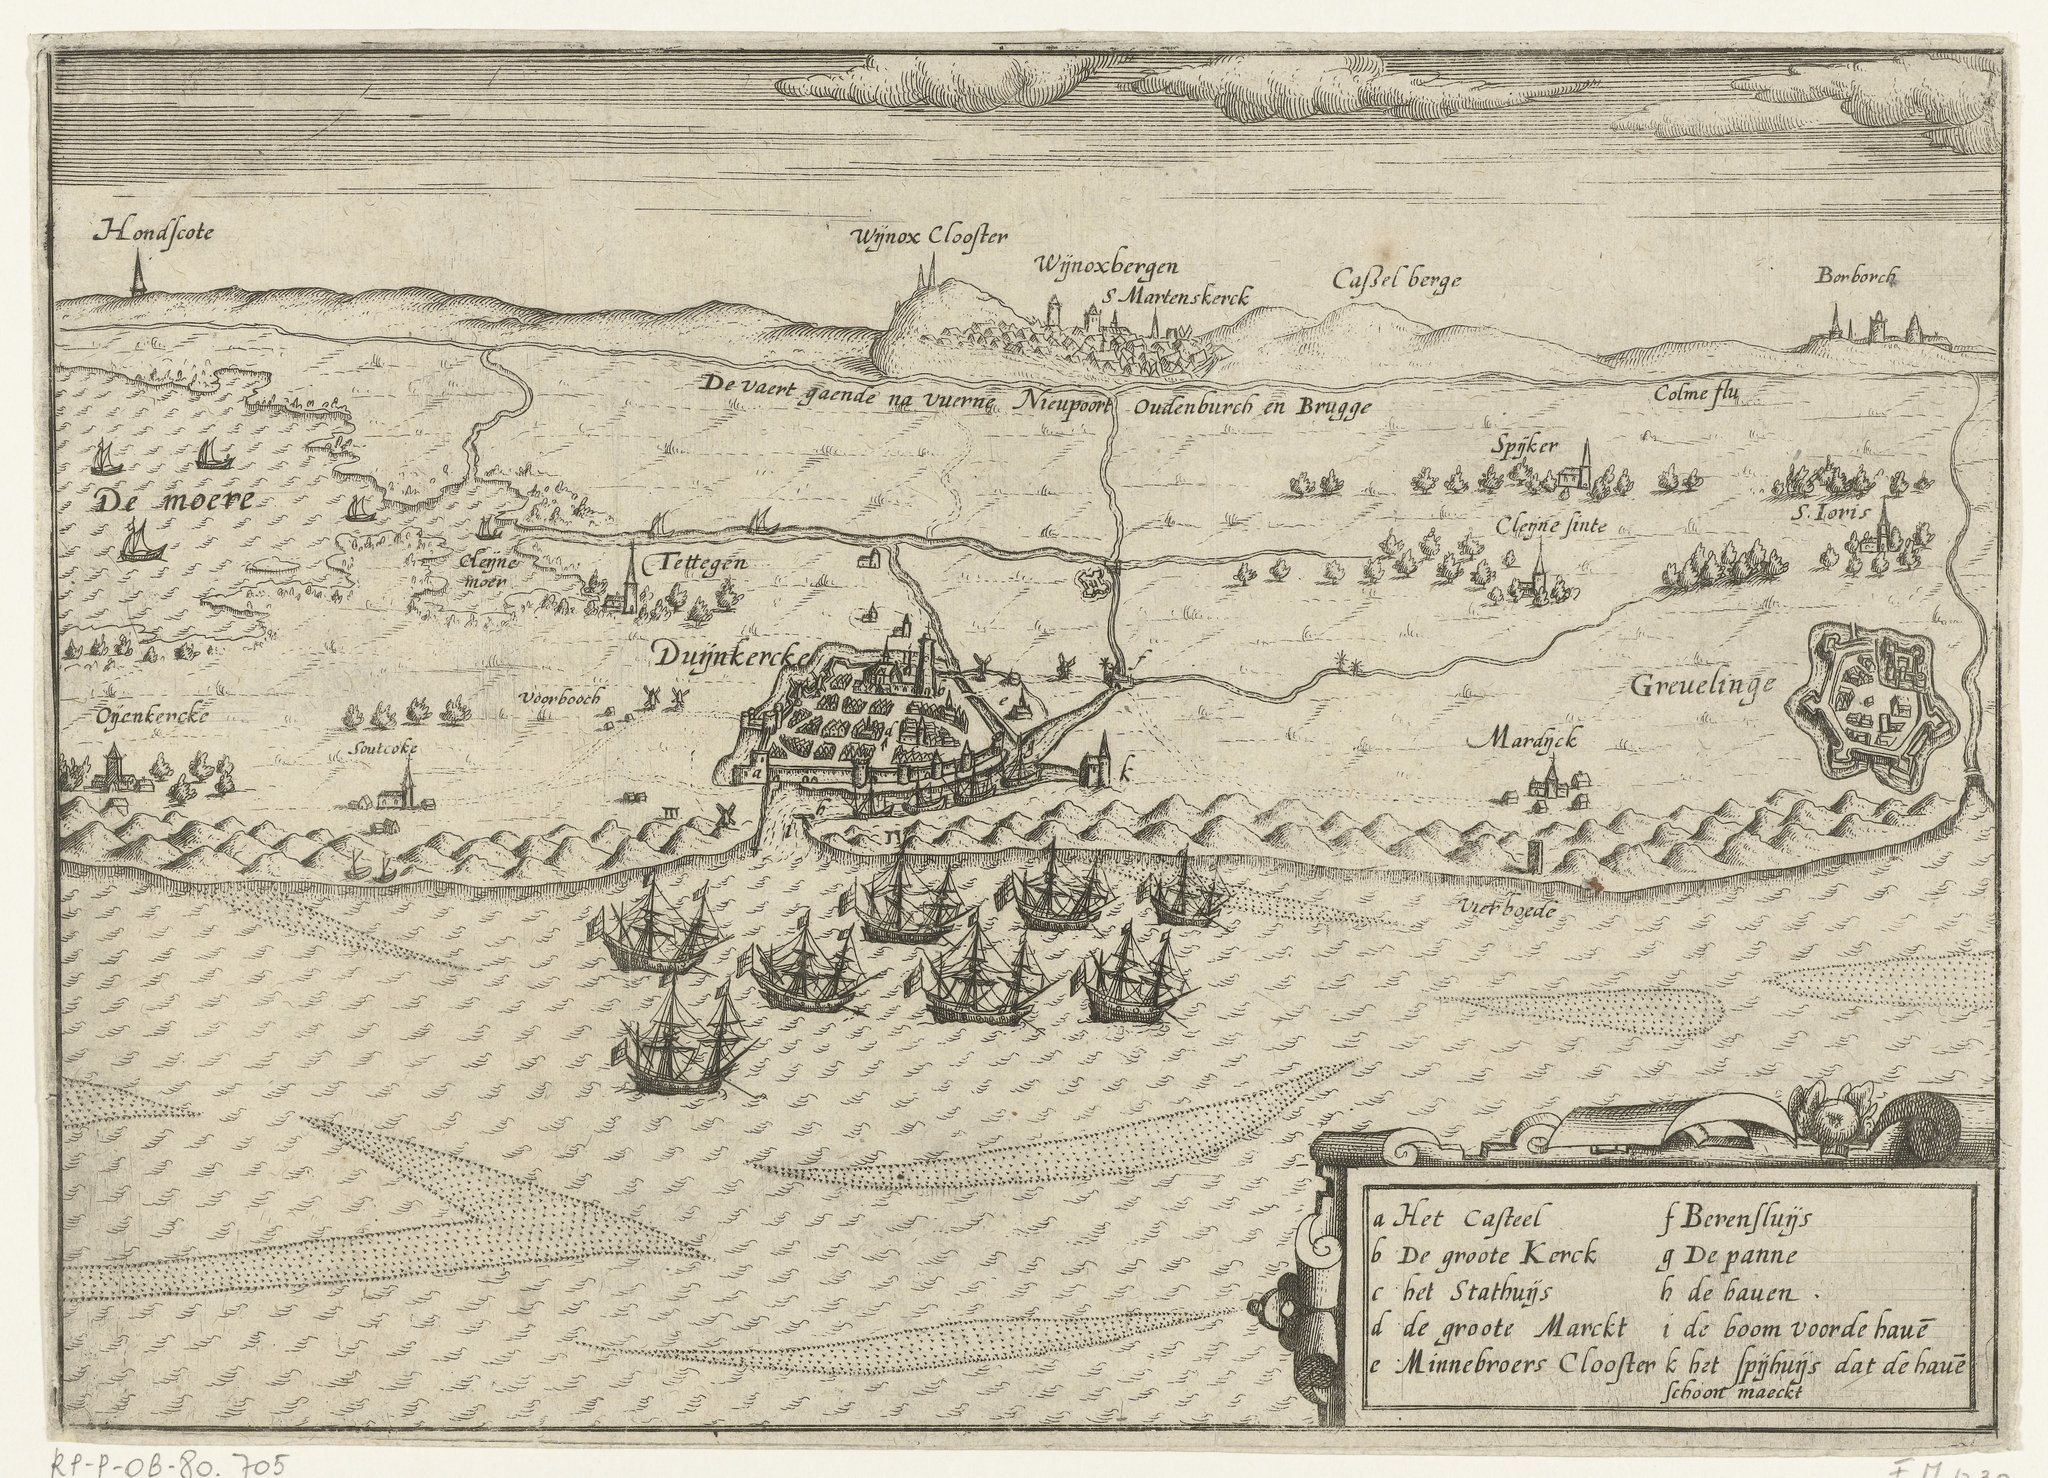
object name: print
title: Hollandse schepen voor anker bij Duinkerke, ca. 1605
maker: Anonymous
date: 1607-1609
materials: paper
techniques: etching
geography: low countries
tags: grevelingen, duinkerke, tachtigjarige oorlog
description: De Vlaamse kust met acht Hollandse schepen liggend voor anker bij Duinkerke, ca. 1605. Rechts Grevelingen, in de verte meerdere Vlaamse dorpen. Rechtsonder een cartouche met legenda a-k voor details in en om de stad, in het Nederlands. Volgens Muller betreft het een voorstelling van de overwinning behaald op de Duinkerker admiraal Adriaan Dirkszoon door de Rotterdamse scheepskapitein genaamd Mooi Lambert, december 1605.